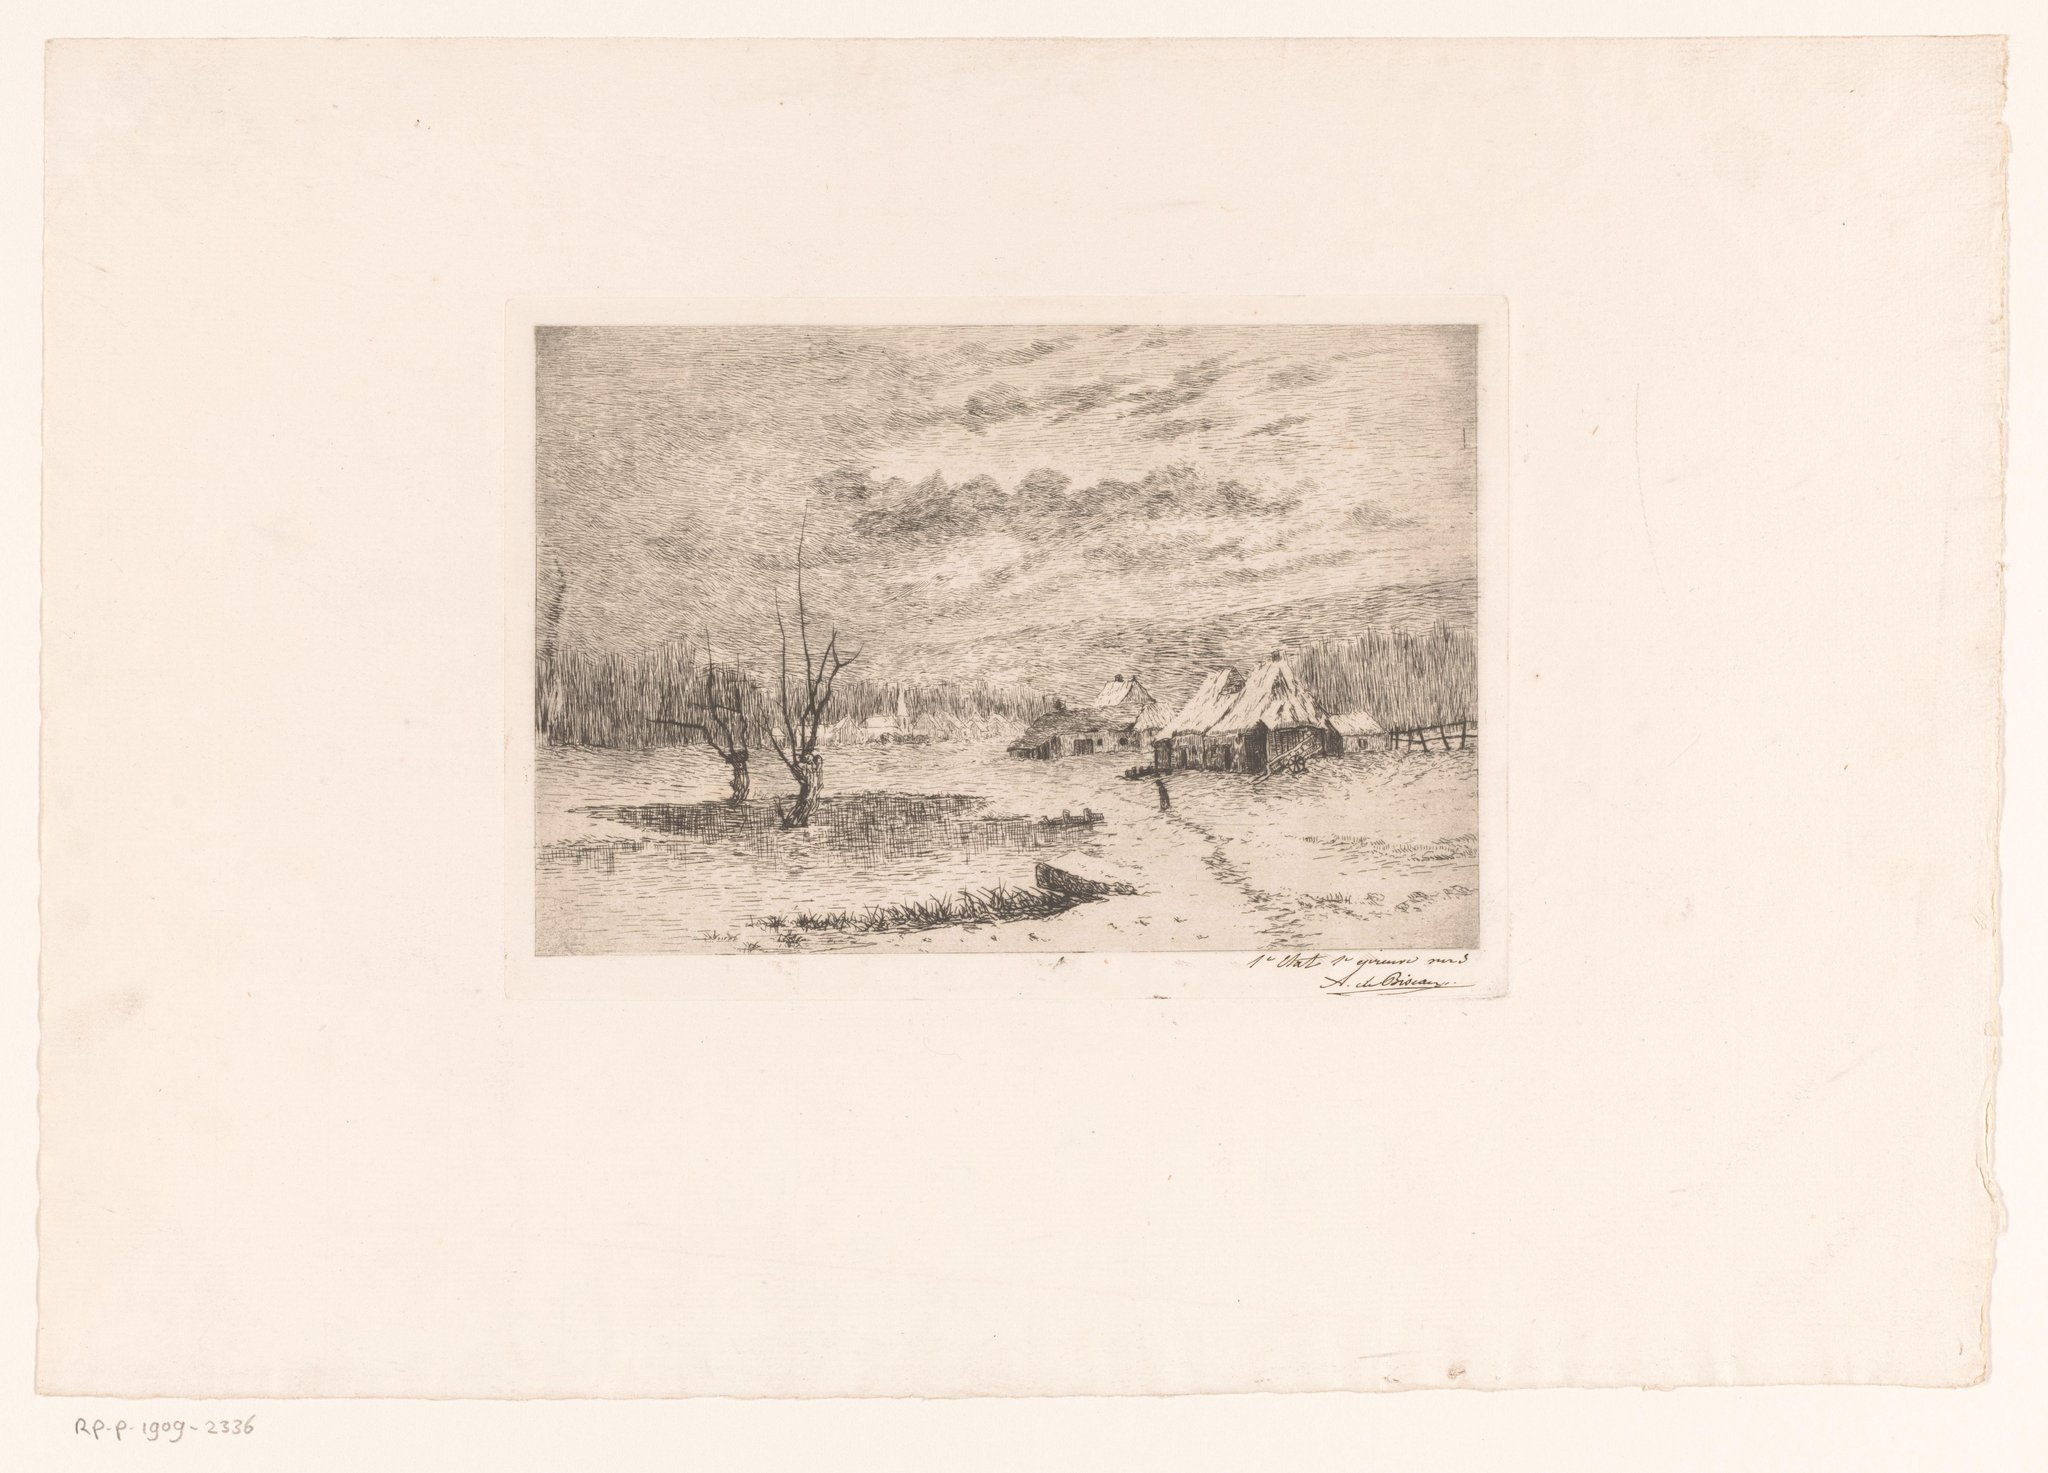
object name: print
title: Sneeuwlandschap met plas en een dorp op de achtergrond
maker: aristide de biseau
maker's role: print maker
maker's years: 1844-1883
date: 1854-1883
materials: paper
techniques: etching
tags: village, winter landscape; landscape symbolizing winter (the four seasons of the year), pond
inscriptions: inscription: ‘1e Etat 1e epreuve nr 3’, collector's mark: Lugt 2228